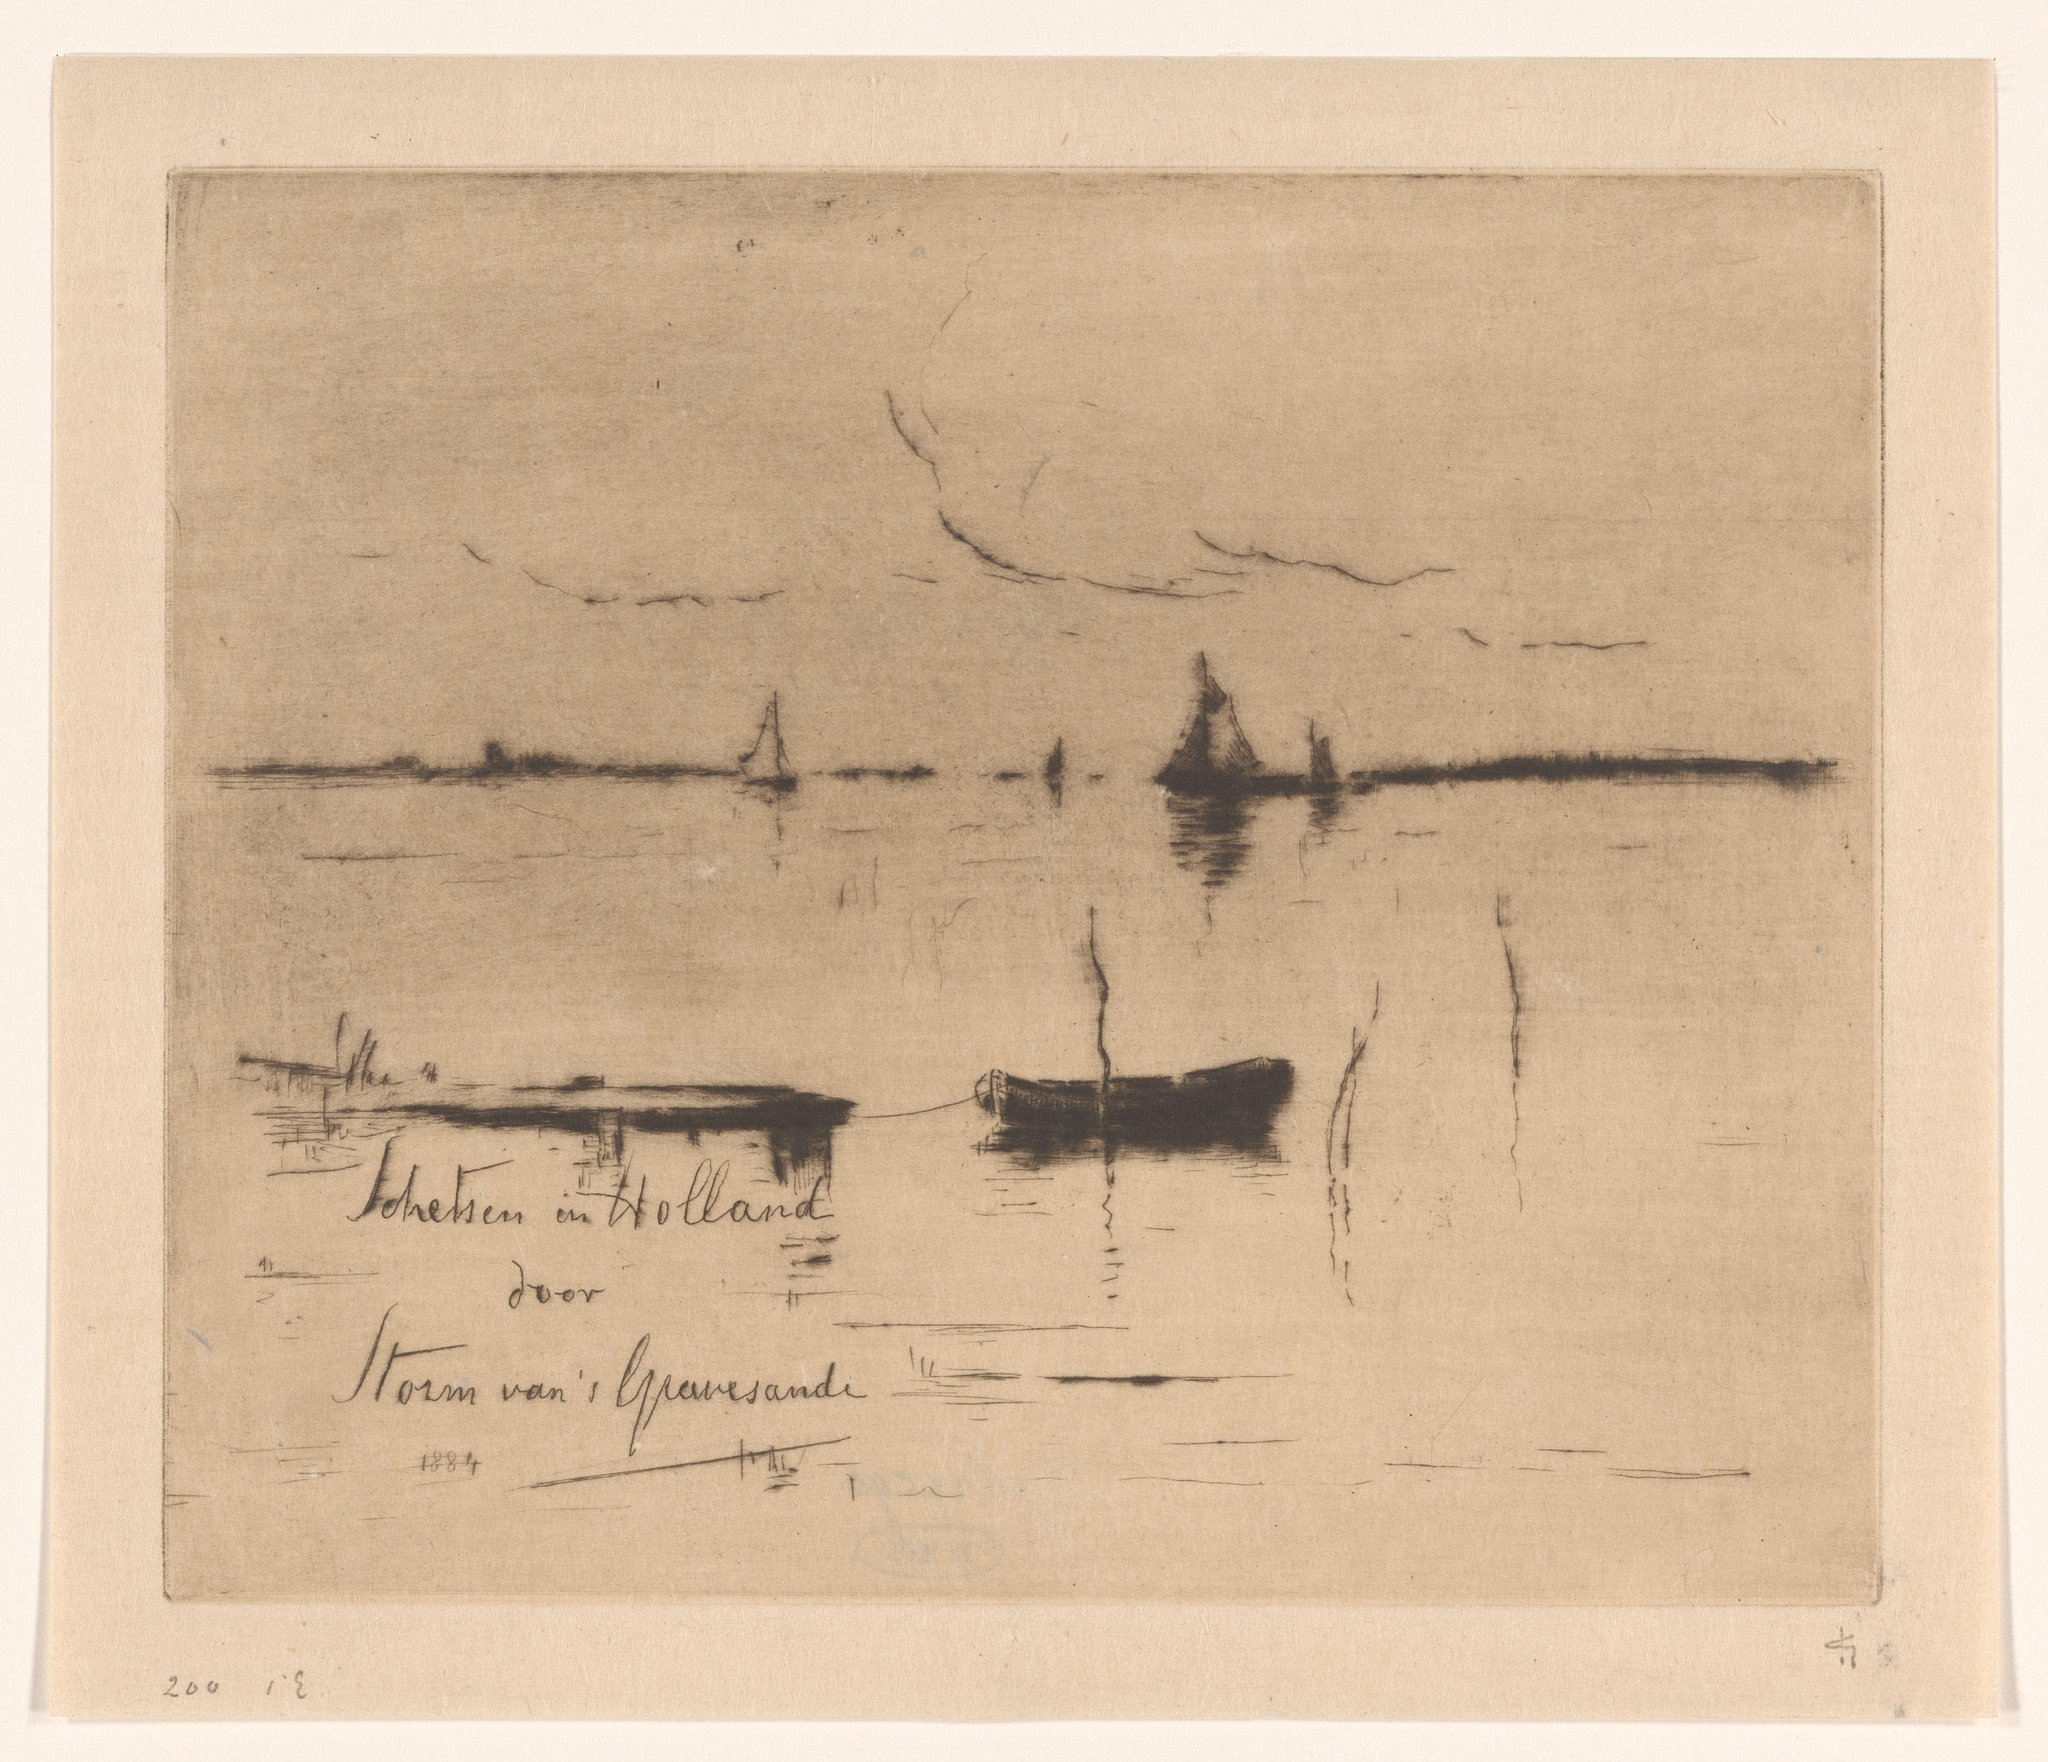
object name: print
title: Schetsen in Holland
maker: carel nicolaas storm van s-gravesande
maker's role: draughtsman, print maker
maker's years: 1841-1924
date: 1884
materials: paper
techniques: drypoint, intaglio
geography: netherlands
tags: river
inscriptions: collector's mark: Lugt 2228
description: Linksonder de tekst: 'Schetsen in Holland door Storm van 's Gravesande".